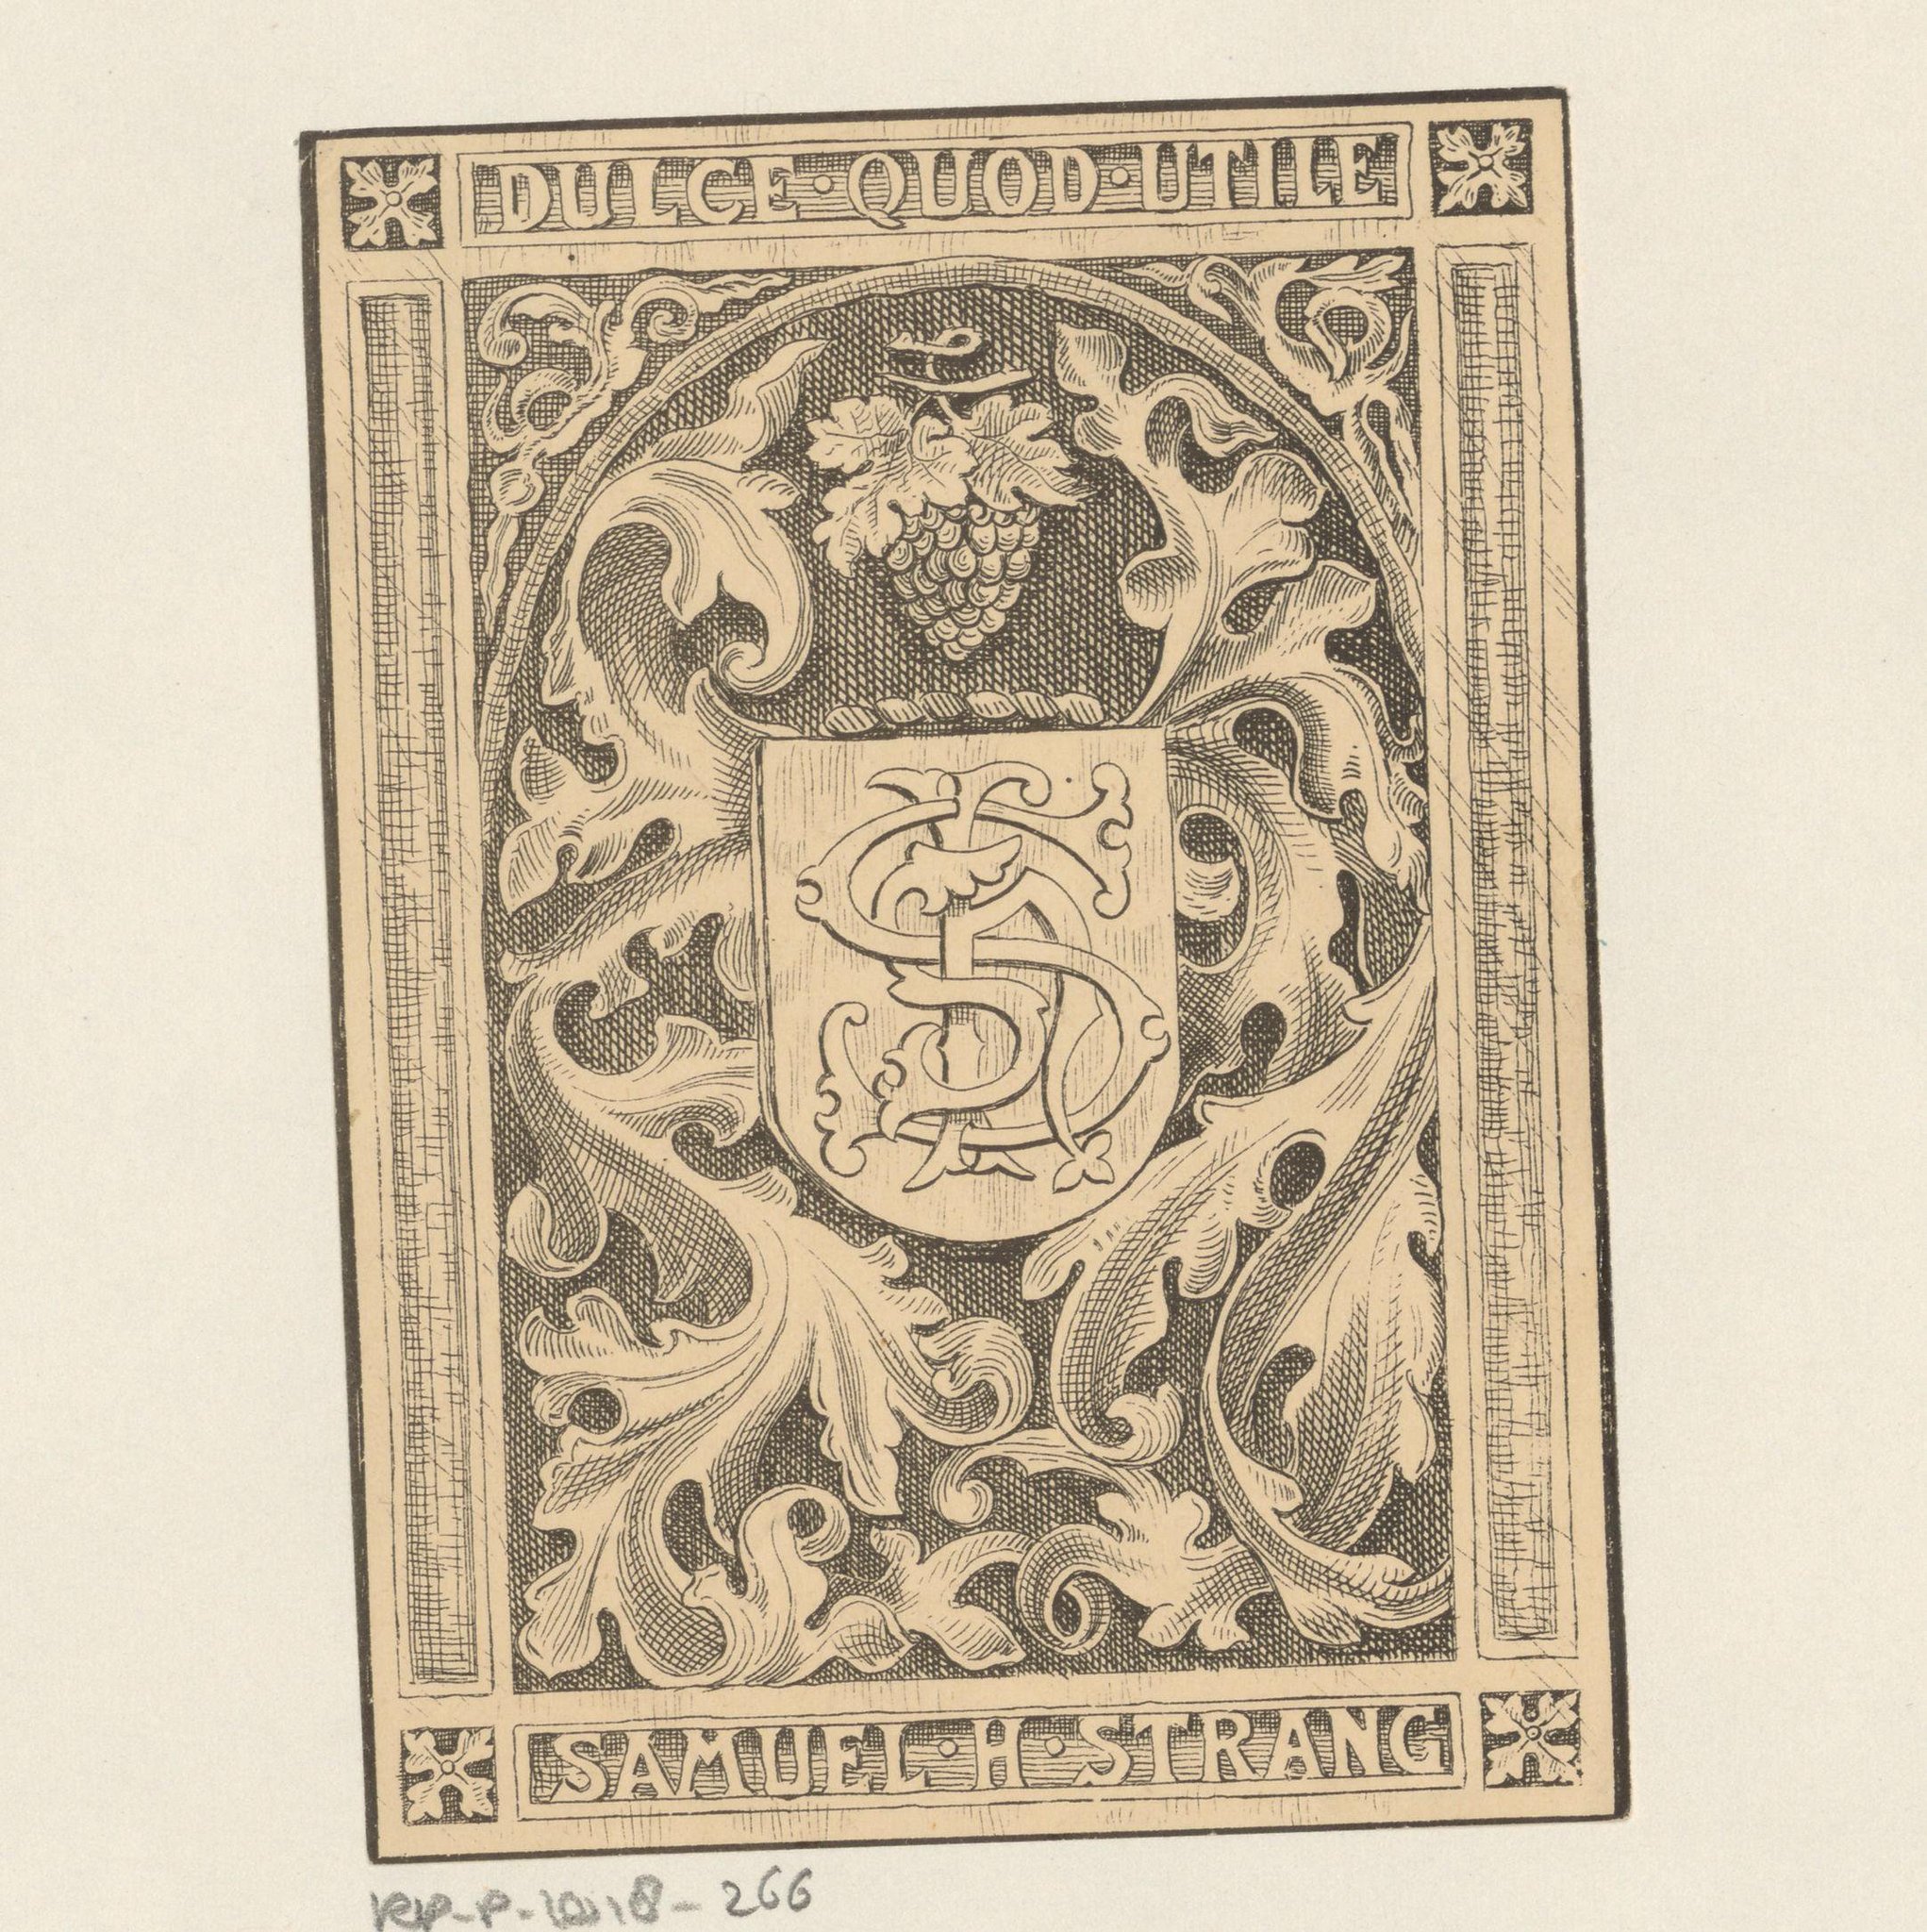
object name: bookplate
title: Dulce quod utile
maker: Anonymous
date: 1880-1949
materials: paper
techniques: lithograph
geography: north and central america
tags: bunch of grapes, armorial bearing, heraldry